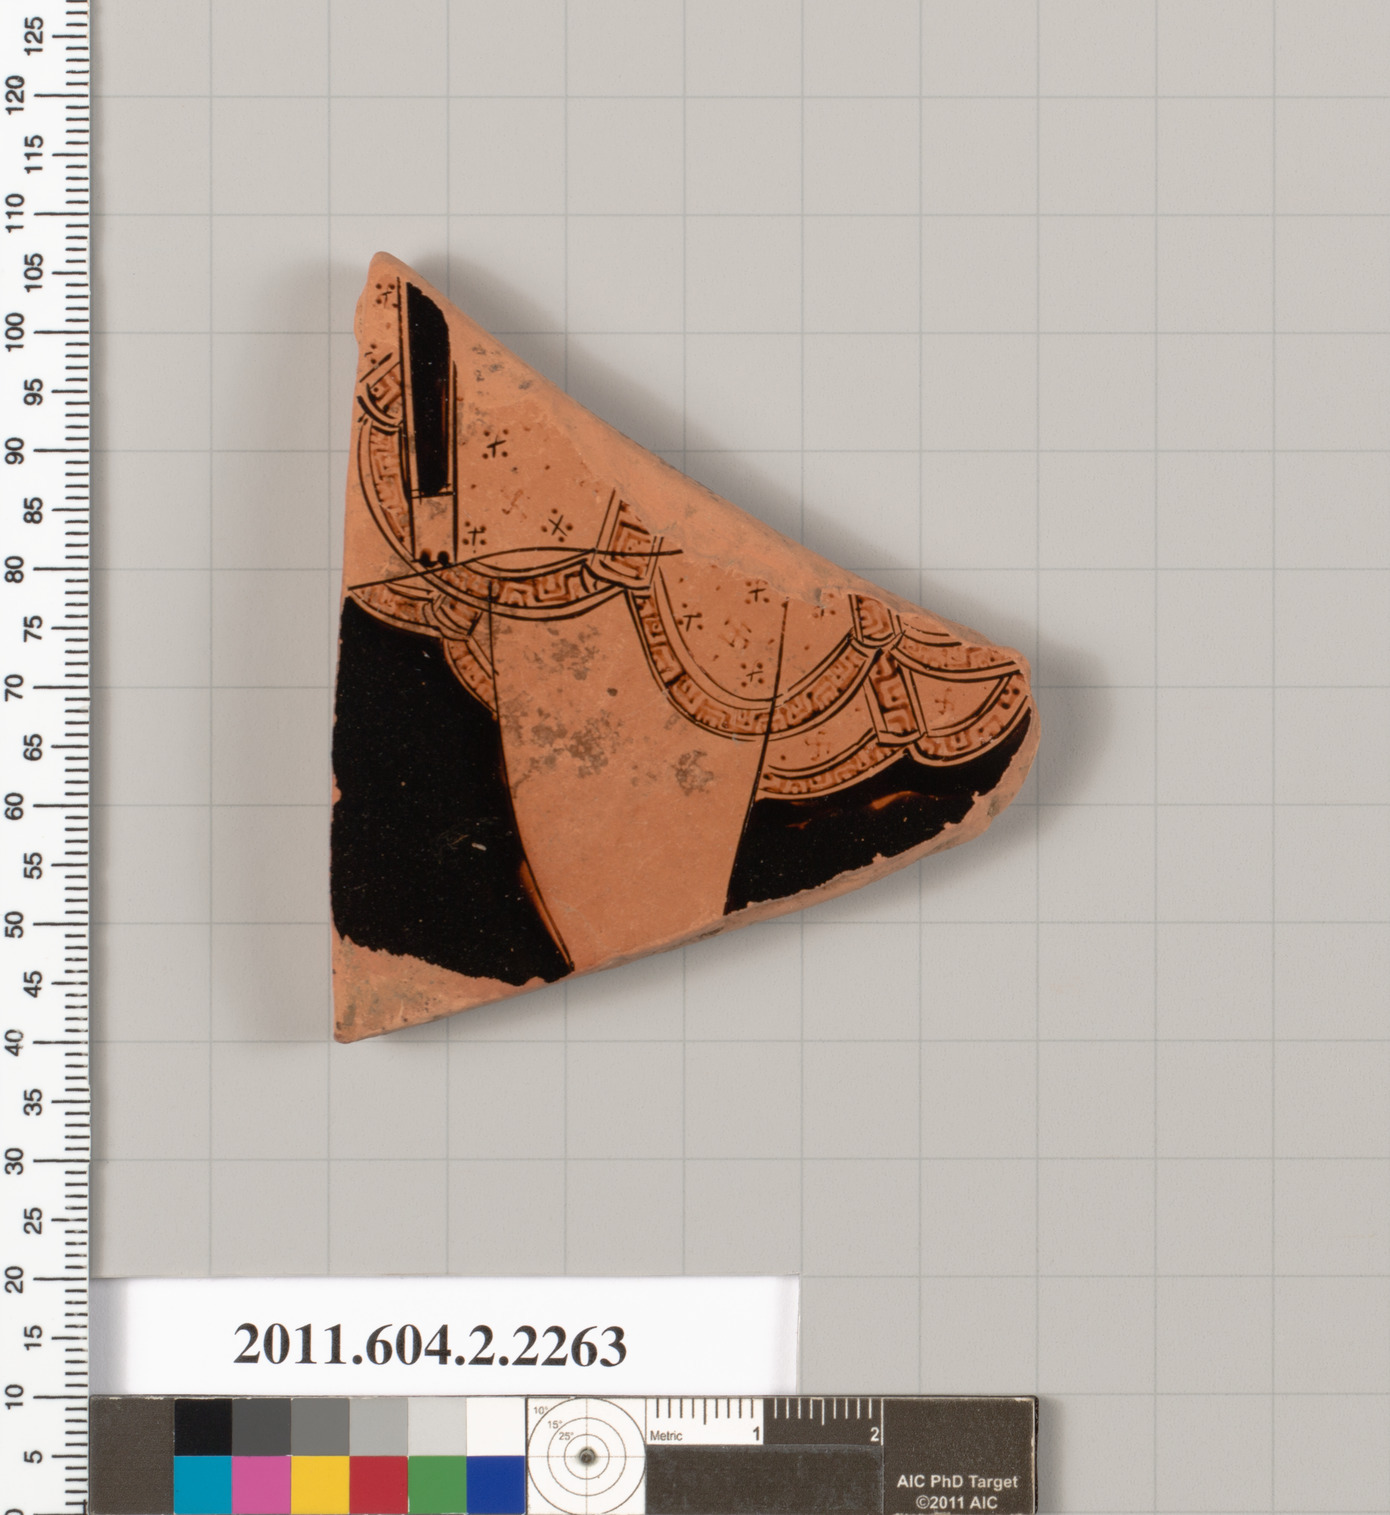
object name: krater fragment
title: Terracotta fragment of a krater (bowl for mixing wine and water)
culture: greek, attic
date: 480-470 BCE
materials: terracotta